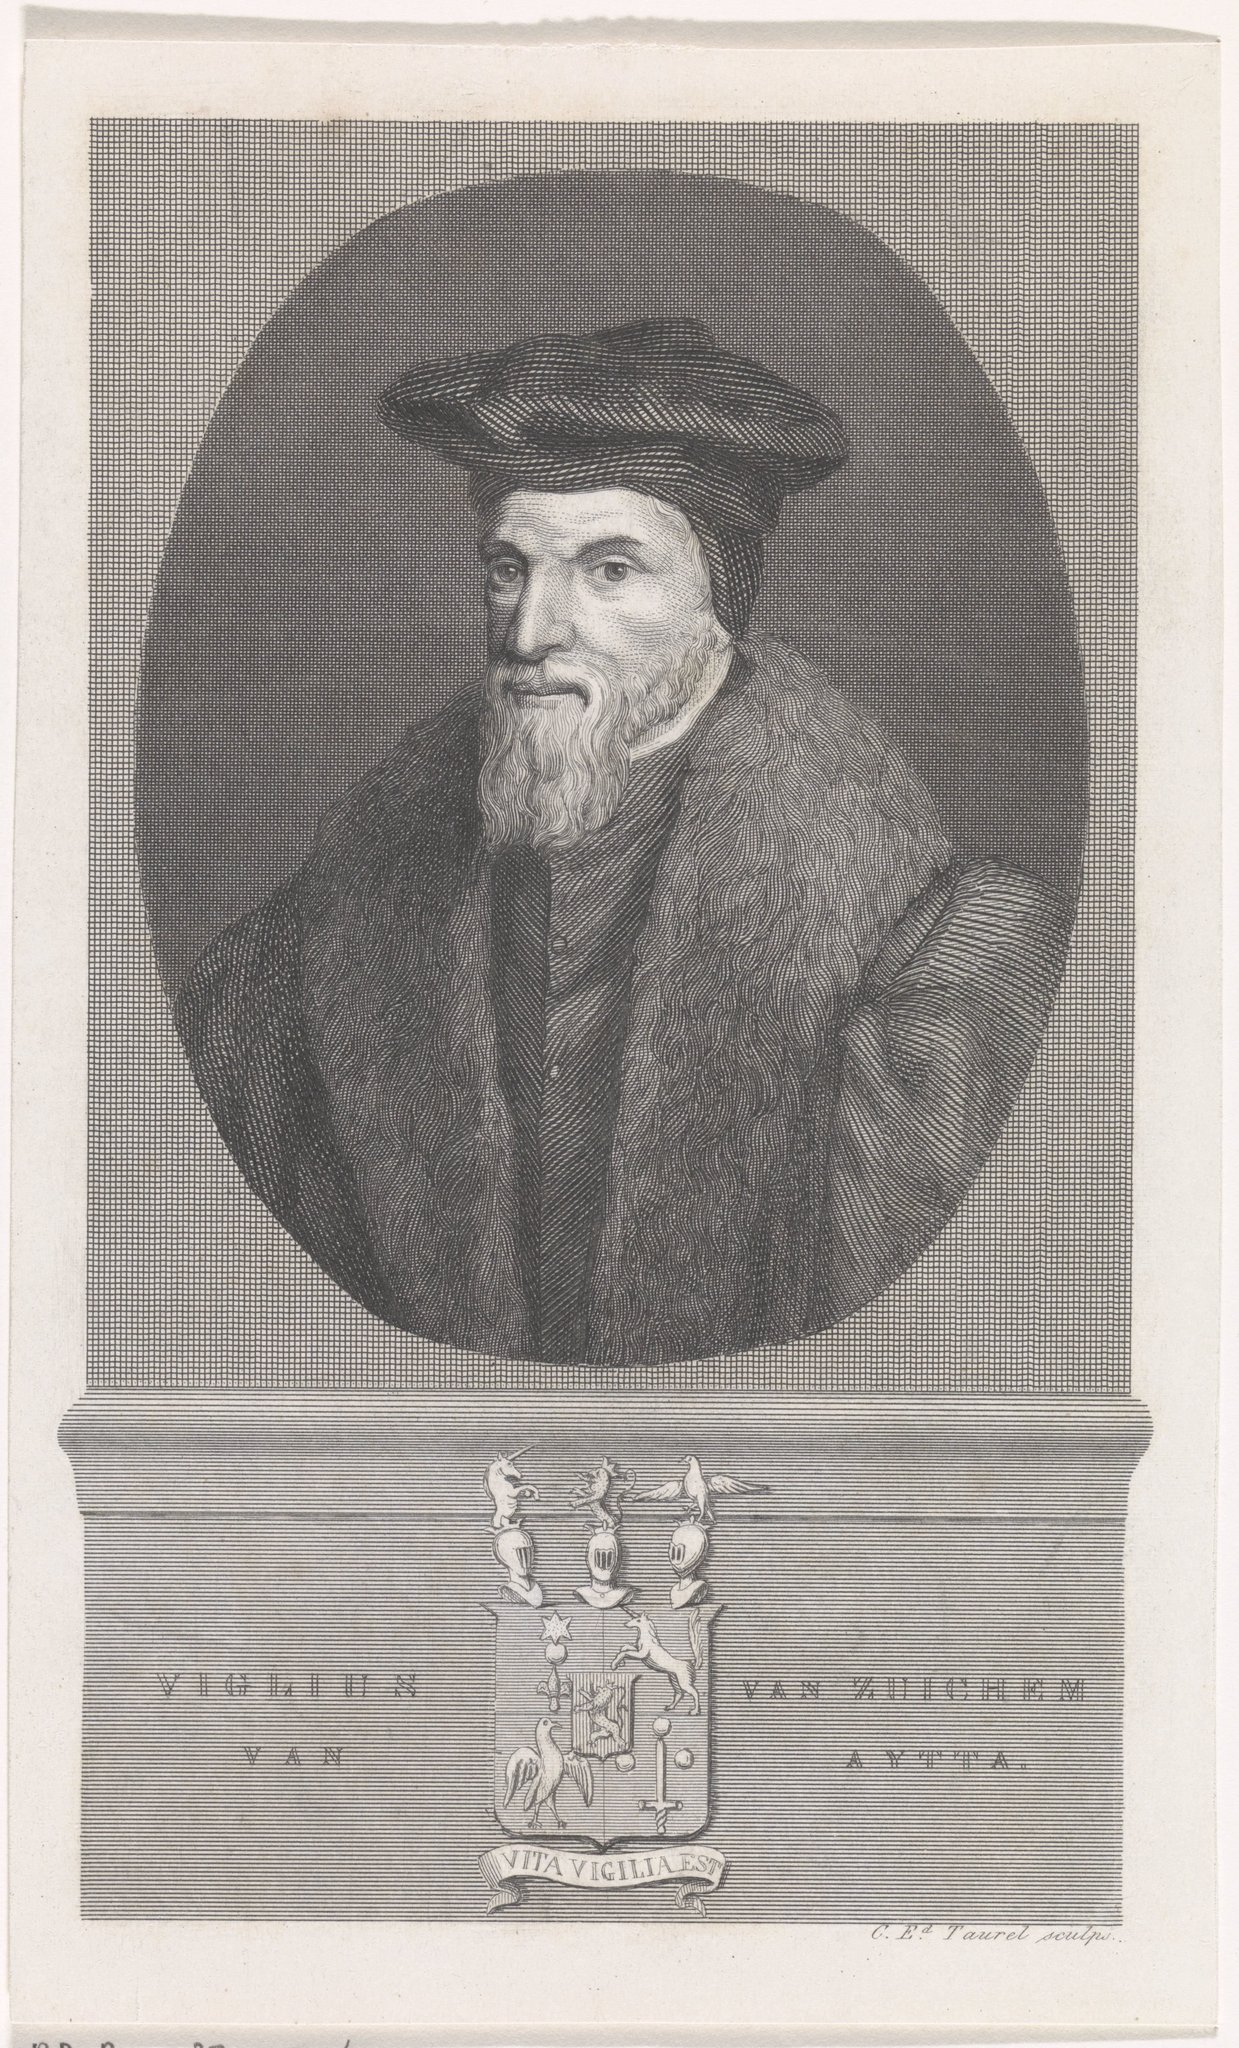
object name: print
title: Portret van Viglius ab Aytta Zuichemus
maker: edouard taurel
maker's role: draughtsman, print maker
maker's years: 1824-1892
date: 1841-1879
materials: paper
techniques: engraving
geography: amsterdam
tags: brussels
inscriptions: collector's mark: Lugt 2228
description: Prent ook gebruikt als illustratie voor: Arend, Johannes Pieter. Algemeene geschiedenis des vaderlands van de vroegste tijden tot op heden. 5 delen. Amsterdam: J.F. Schleijer, 1841-1884. dl. II.5, p. 18.